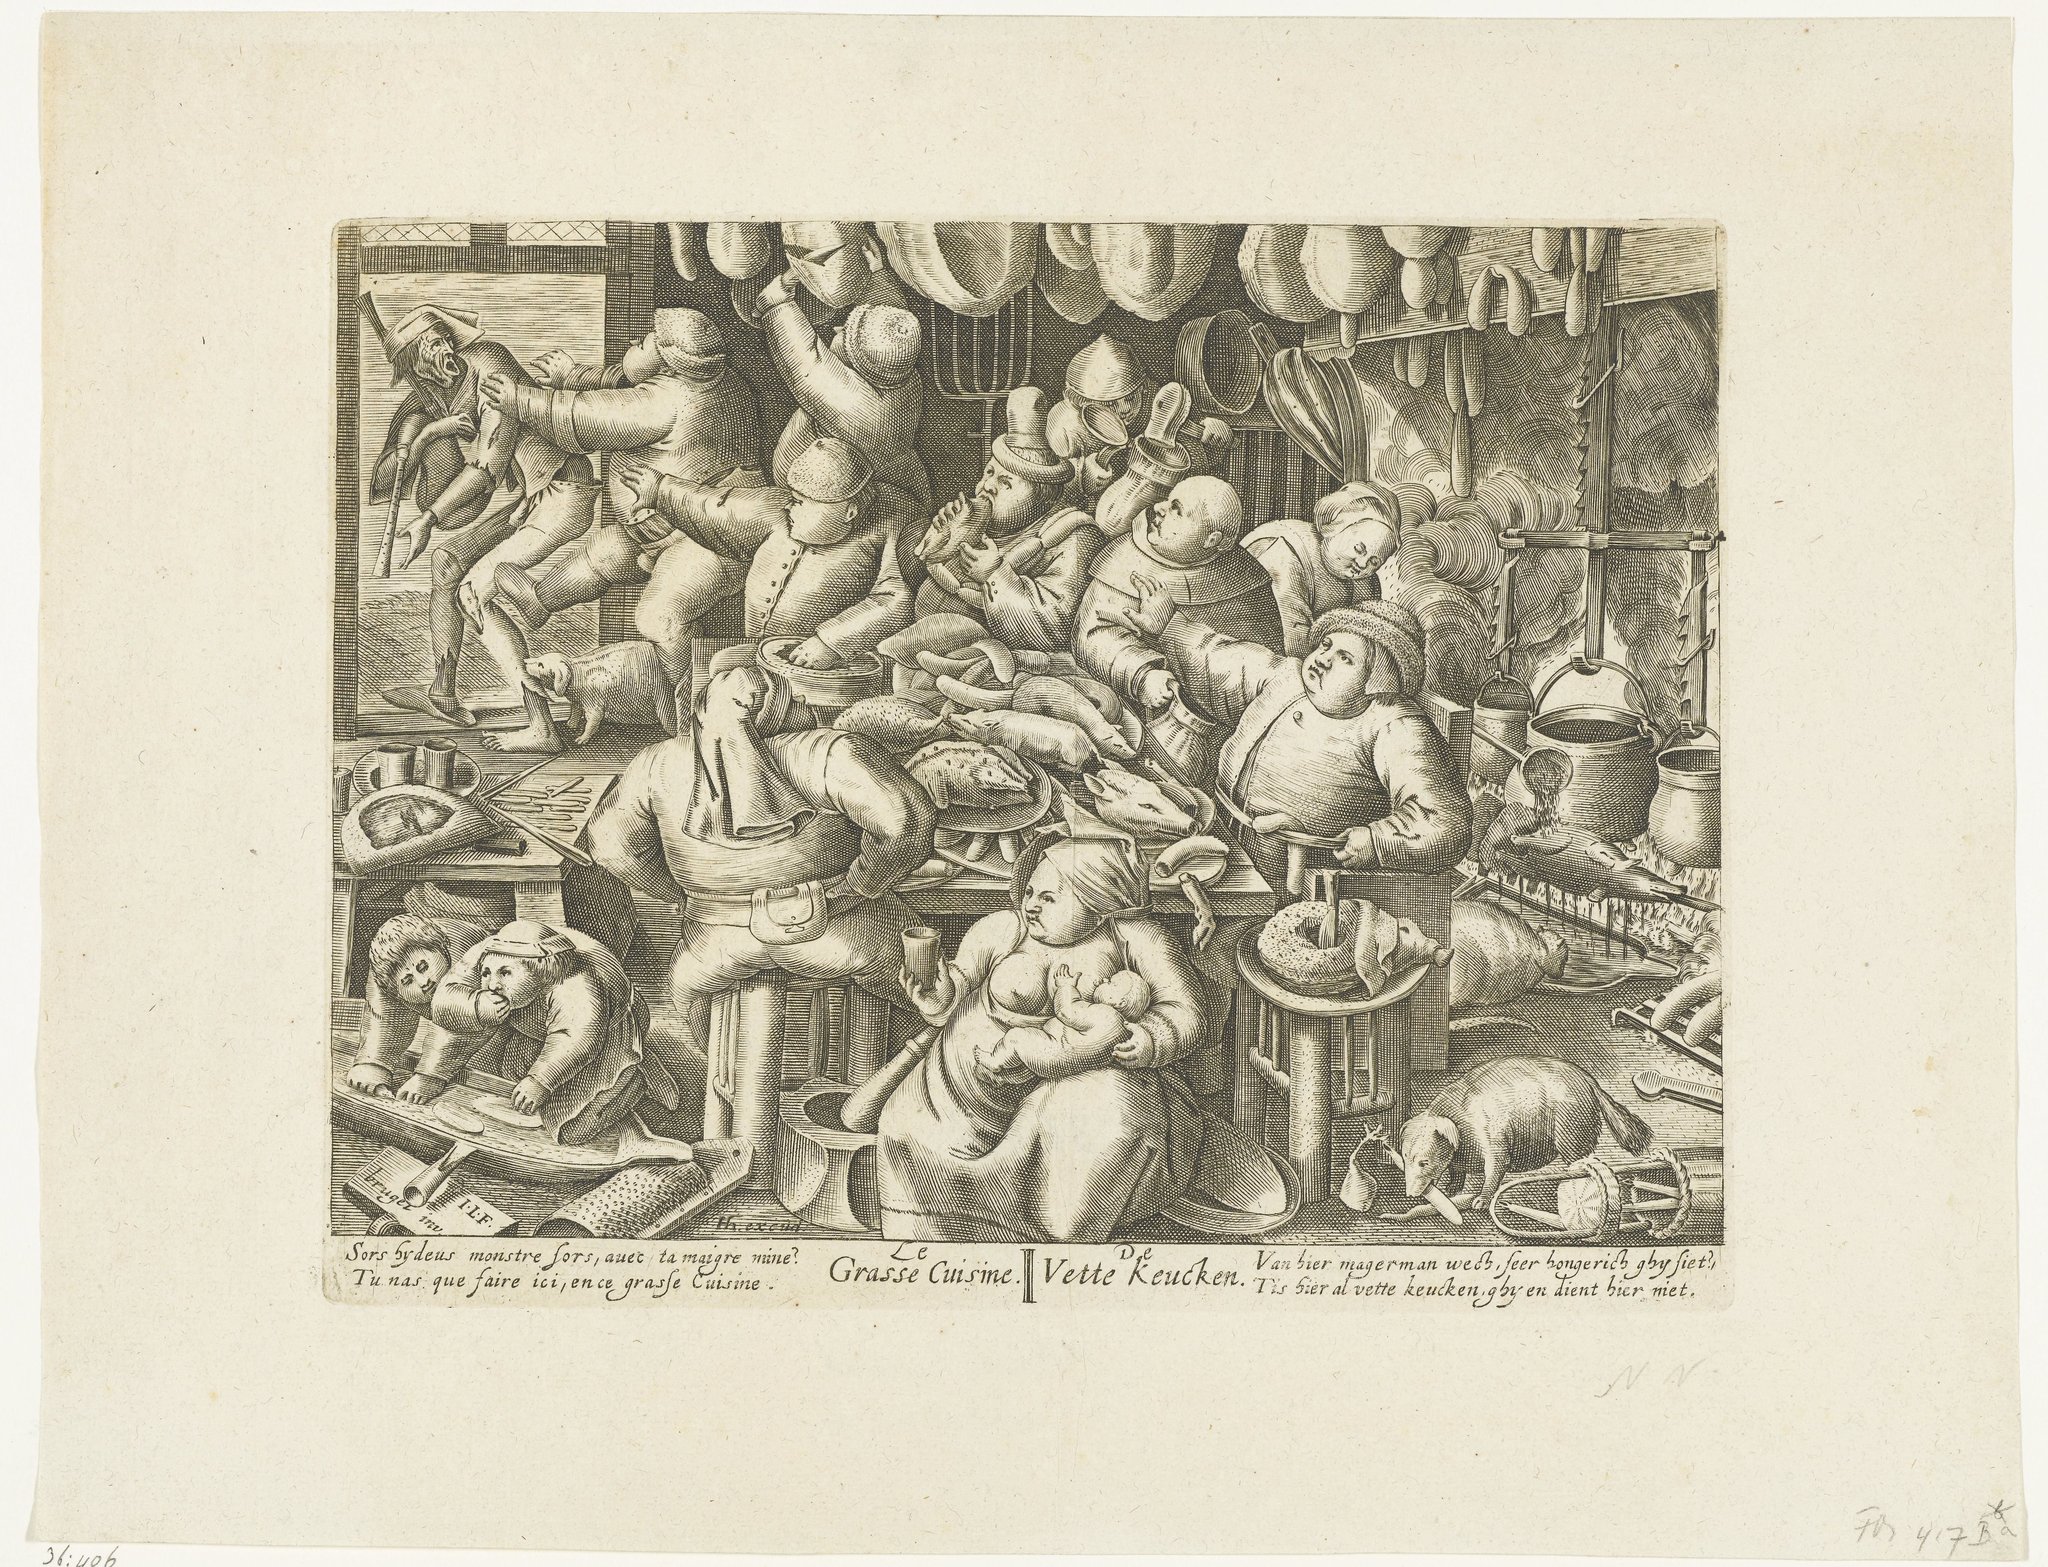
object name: print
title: De vette keuken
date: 1563-1573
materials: paper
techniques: engraving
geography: southern netherlands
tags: kitchen-interior, rich kitchen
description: De vette keuken. Interieur waarin een groep van dikke mensen zich aan allerlei eten en drinken te goed doet. Rechts wordt in de haard gekookt en gebraden. Op de voorgrond links twee met eten spelende kinderen en in het midden een drinkende vrouw die een kind de borst geeft, links een drinkende monnik of priester. Op de achtergrond wordt een armoedige magere man met doedelzak de deur uit gejaagd. Met onderschrift van twee regels in het Frans en twee regels in het Nederlands. Zie pendant.